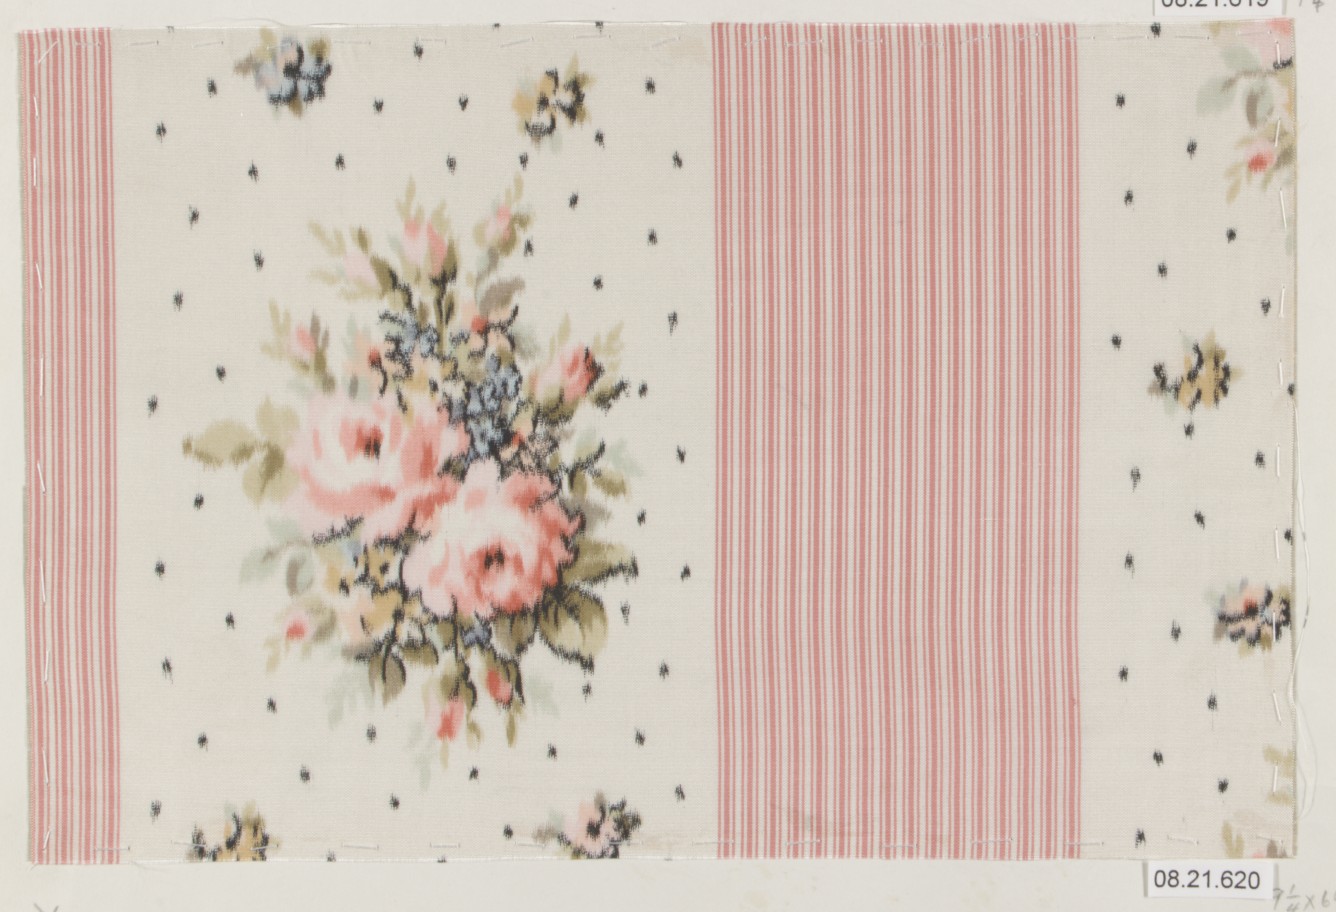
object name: textile sample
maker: Anonymous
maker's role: designer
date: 1900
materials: silk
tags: flowers